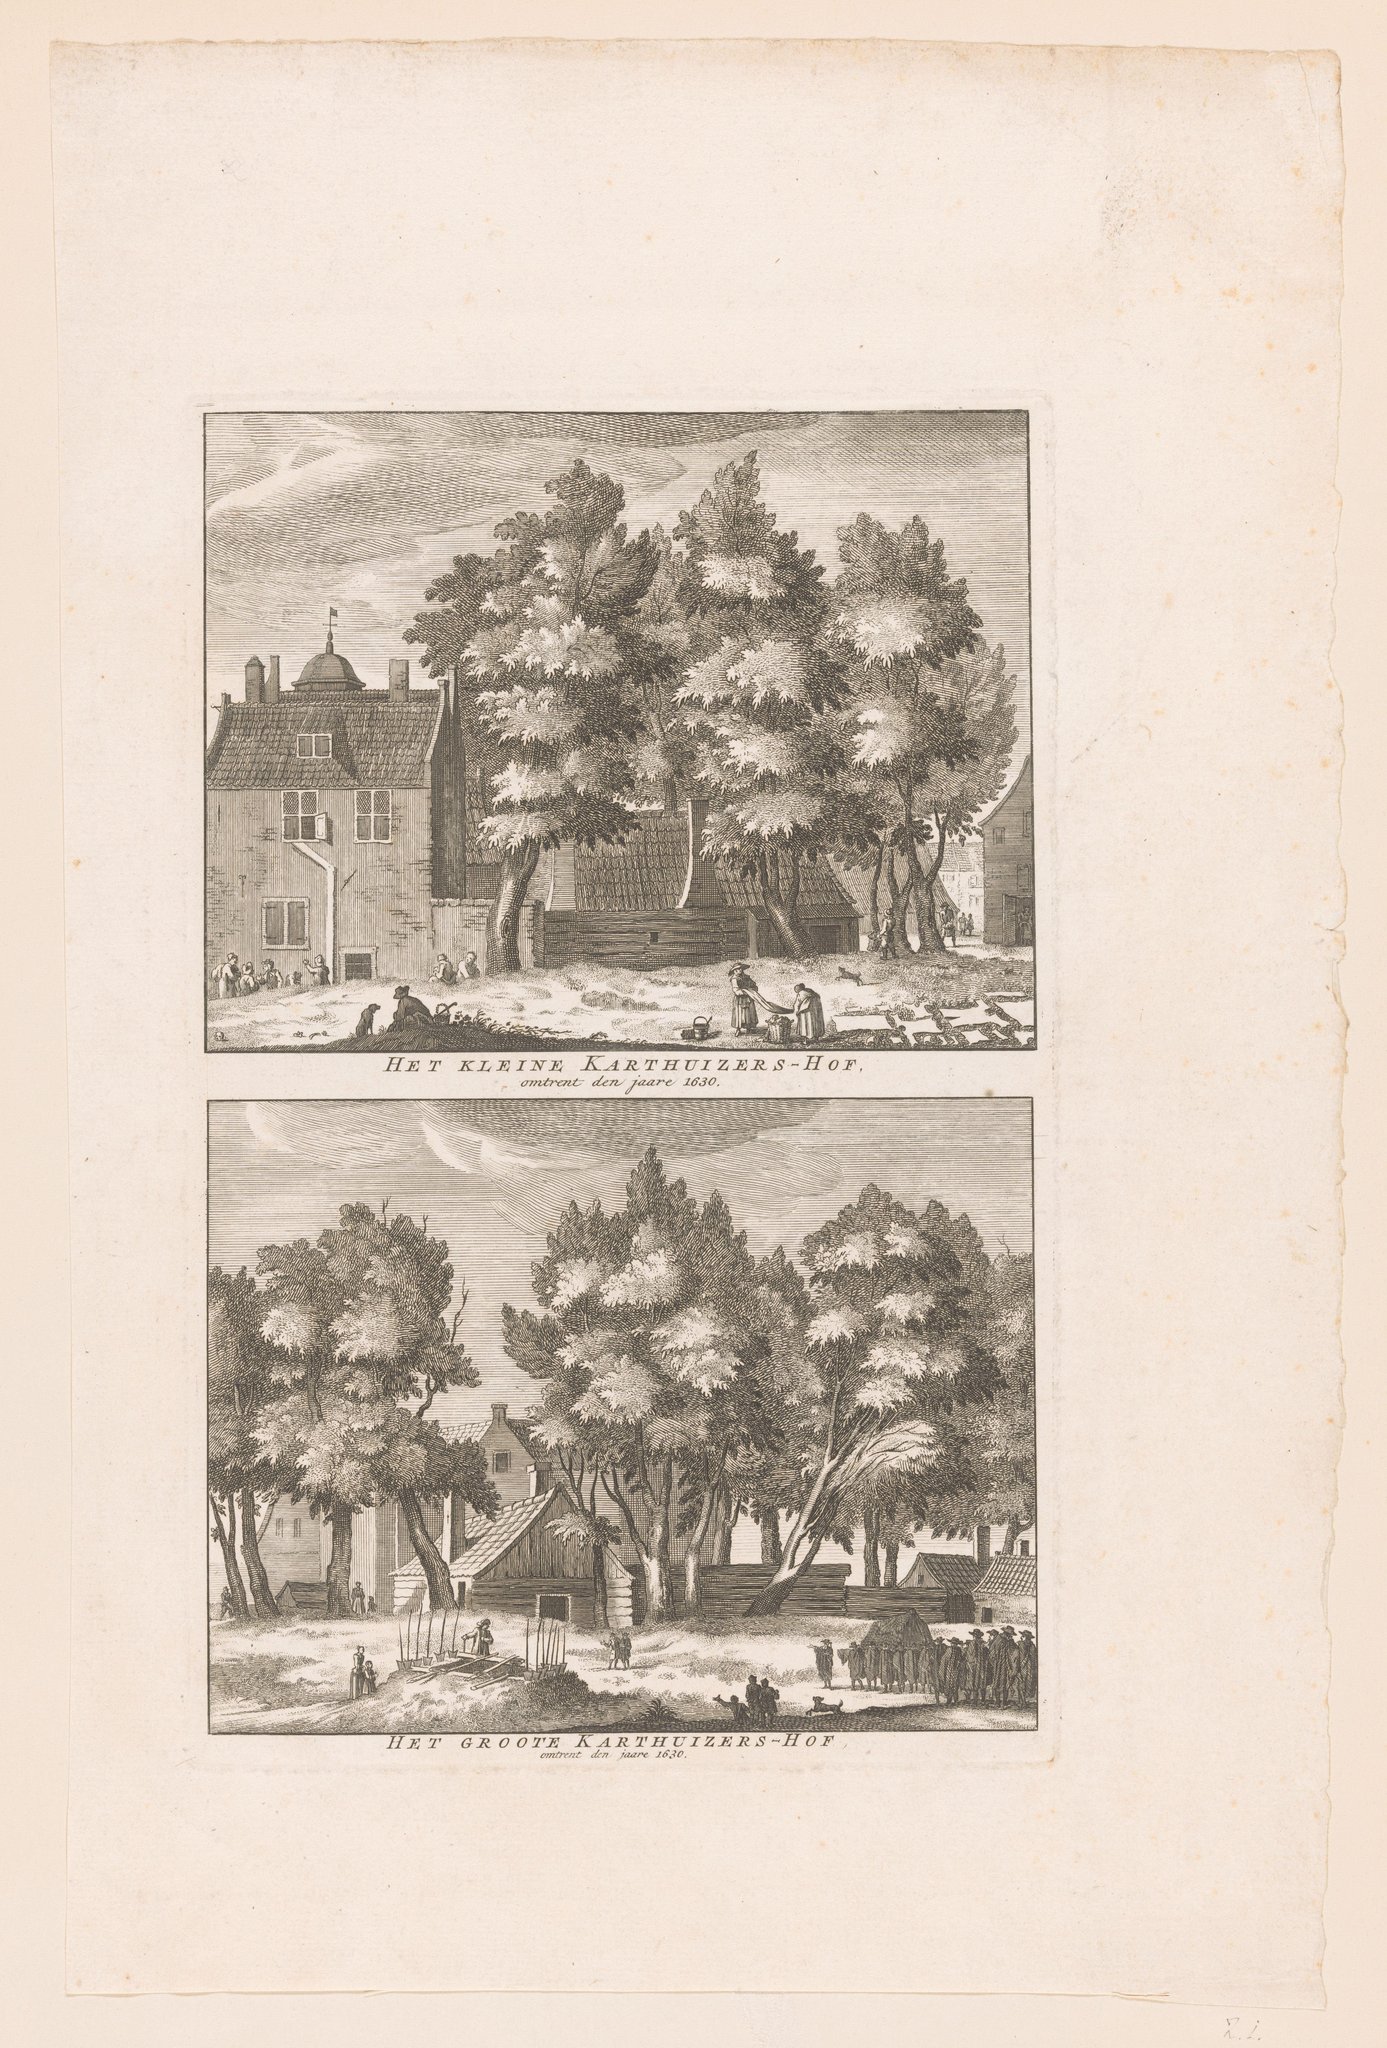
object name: print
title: Het Kleine Karthuizers-Hof, omtrent den jaare 1630 / Het Groote Karthuizers-Hof, omtrent den jaare 1630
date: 1760-1767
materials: paper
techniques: etching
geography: amsterdam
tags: trees, civic architecture; edifices; dwellings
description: Prent verschenen in: Wagenaar, Jan. Amsterdam, in zyne opkomst, aanwas geschiedenissen, voorregten, koophandel, gebouwen, kerkenstaat, schoolen, schutterye, gilden en regeeringe, beschreven door Jan Wagenaar, historieschryver de Stad. Amsterdam: Isaak Tirion, 1760-1767.